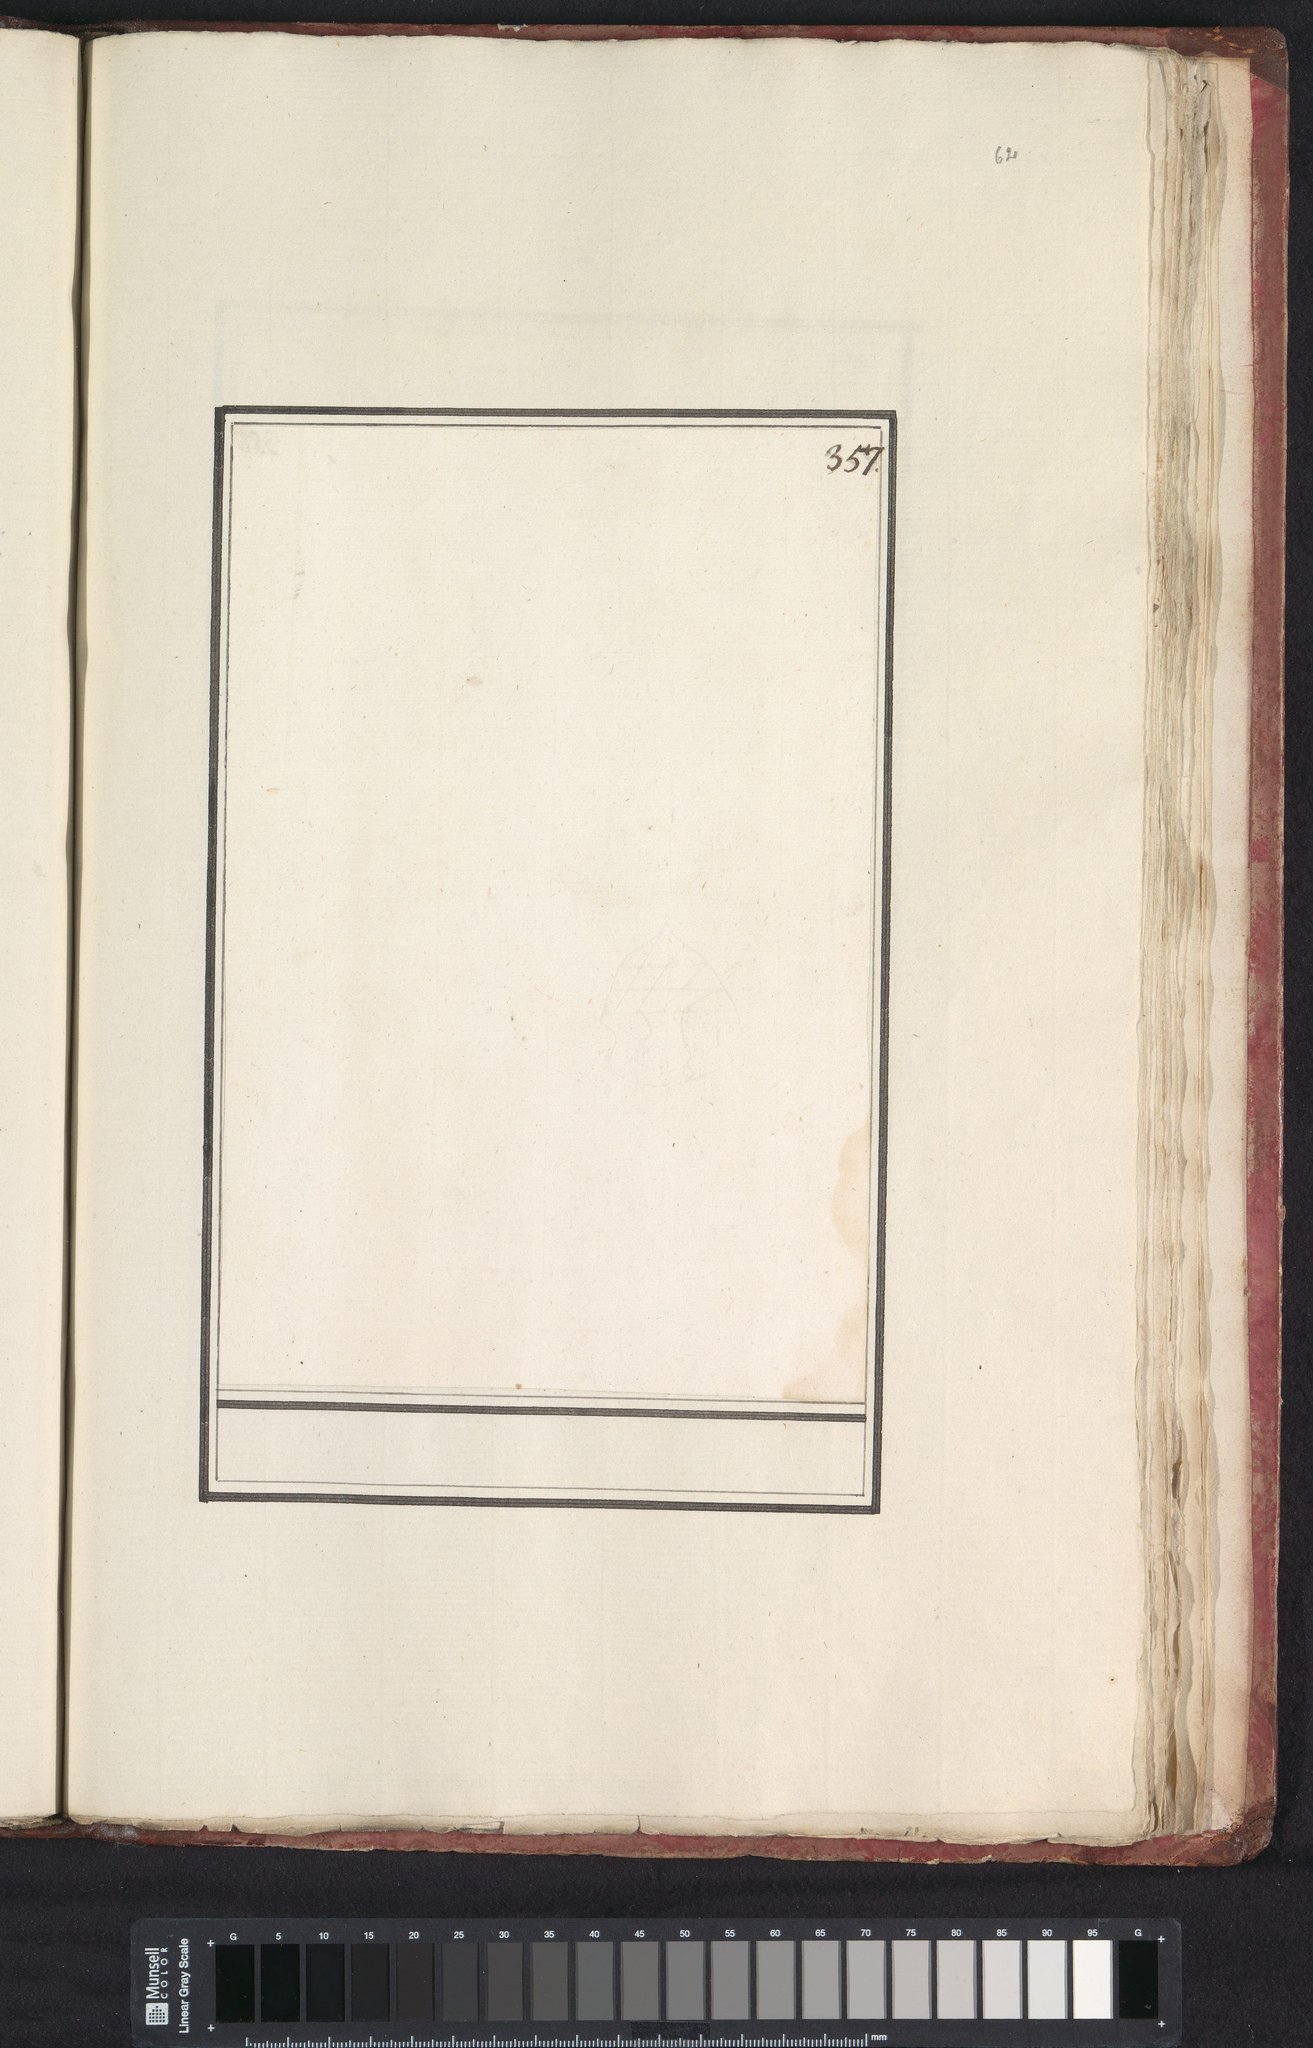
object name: drawing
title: Omlijsting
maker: Anonymous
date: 1809-1814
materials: paper, pencil, watercolor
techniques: brush, pen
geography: southern netherlands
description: Lege omlijsting. Rechtsboven genummerd: 357. Onderdeel van het vierde album met tekeningen van bloemen en paddestoelen. Elfde van twaalf albums met tekeningen van dieren, vogels en planten bekend rond 1600, gemaakt in opdracht van keizer Rudolf II. Met toelichting in Nederlands, Latijn en Frans.